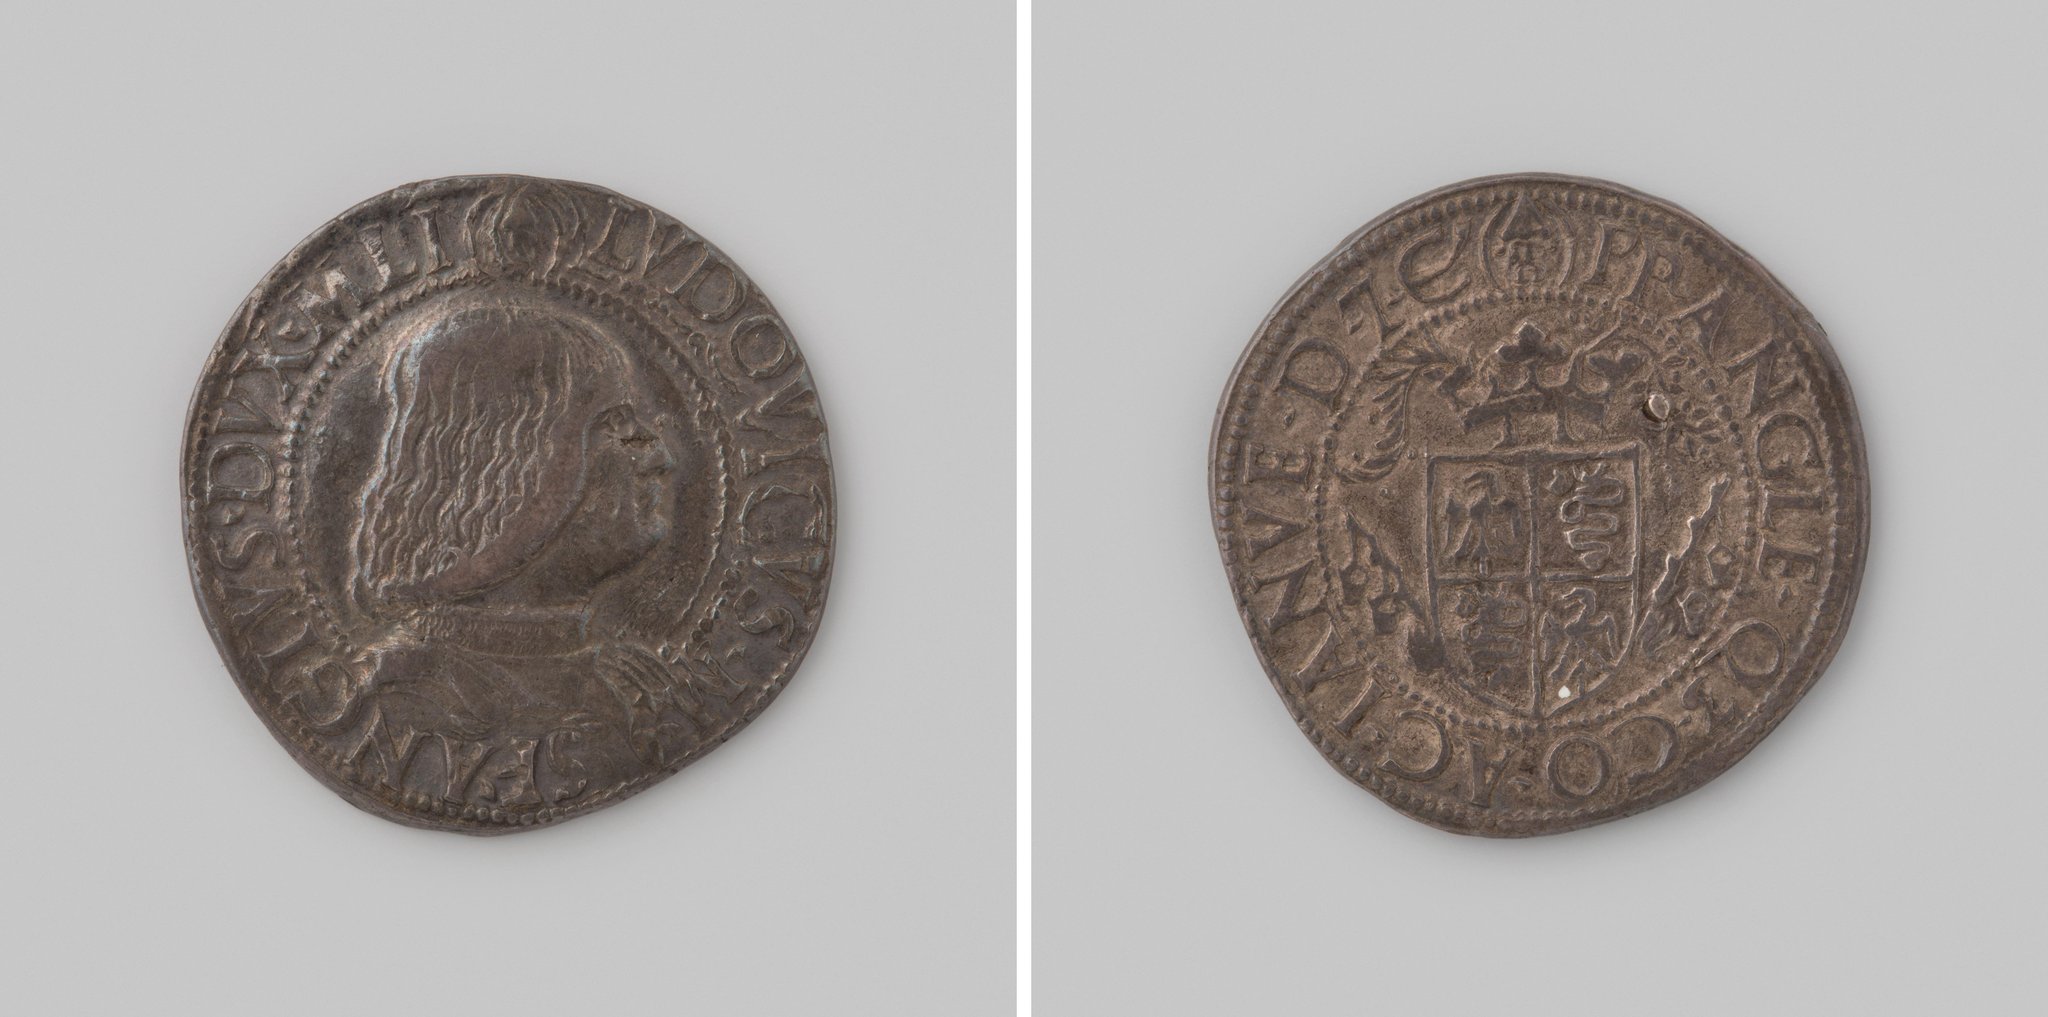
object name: coin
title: Milaan, testone, hertog Ludovico Maria Sforza, 1494-1500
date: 1494-1500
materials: silver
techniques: striking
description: Zilveren munt. Voorzijde: portret van de hertog naar rechts. Keerzijde: versierd gekroond samengesteld wapenschild.